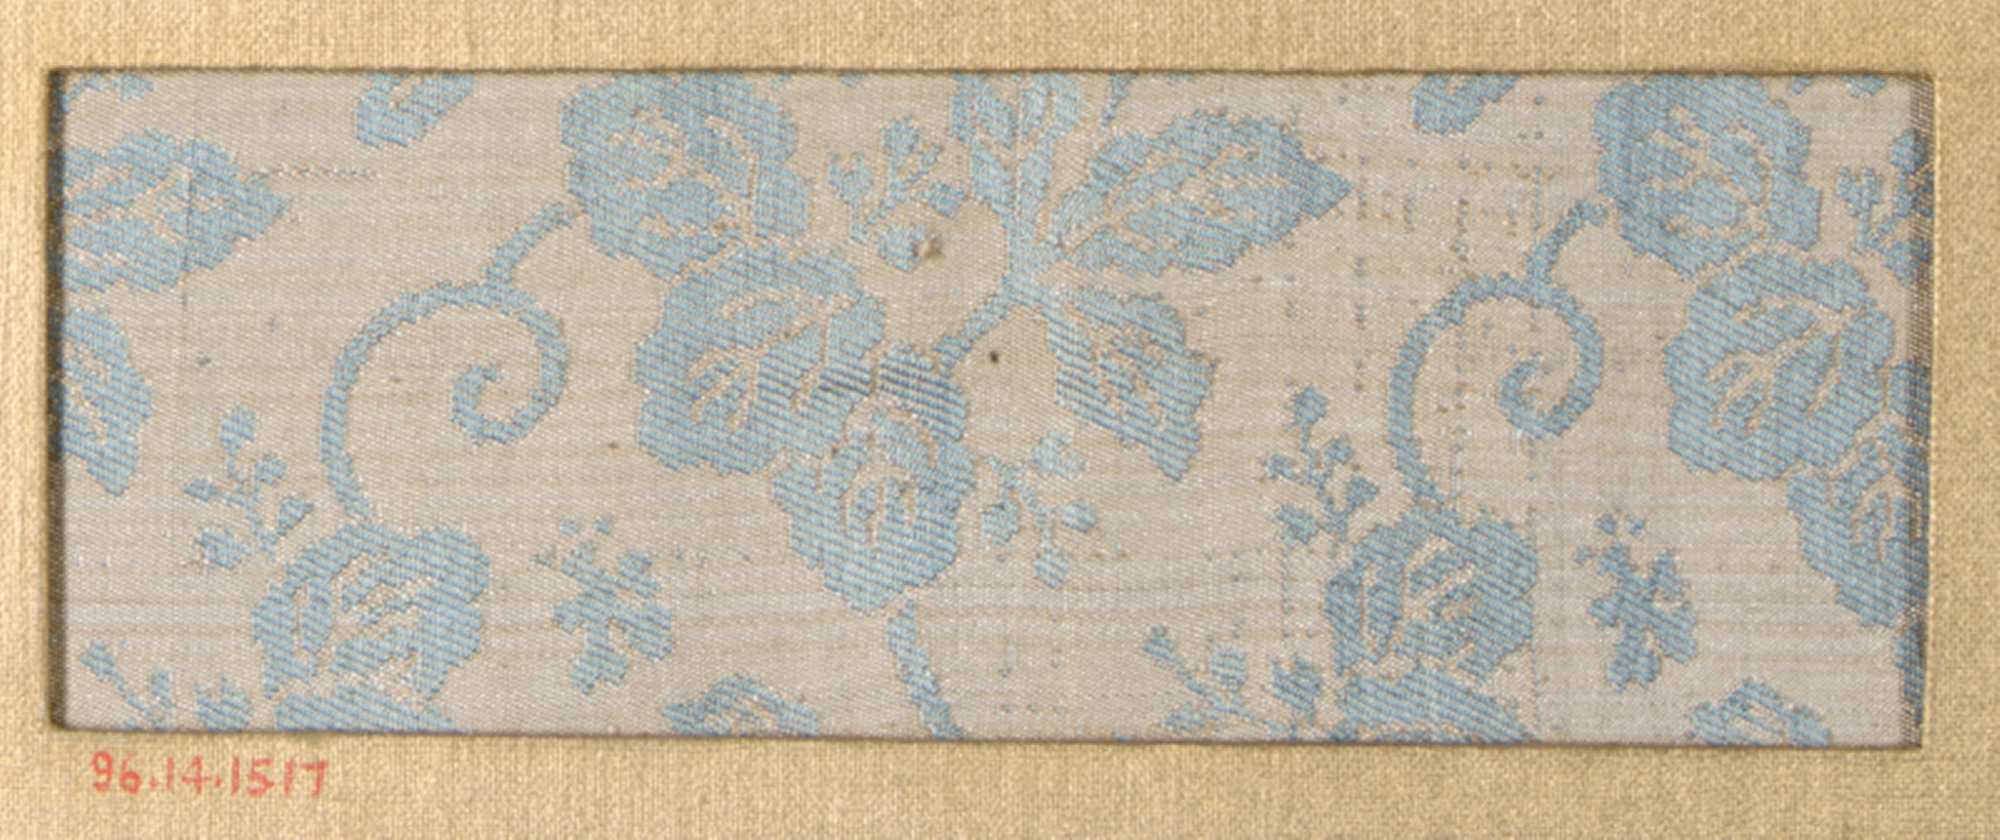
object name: piece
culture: japanese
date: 1701-1900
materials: silk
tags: flowers